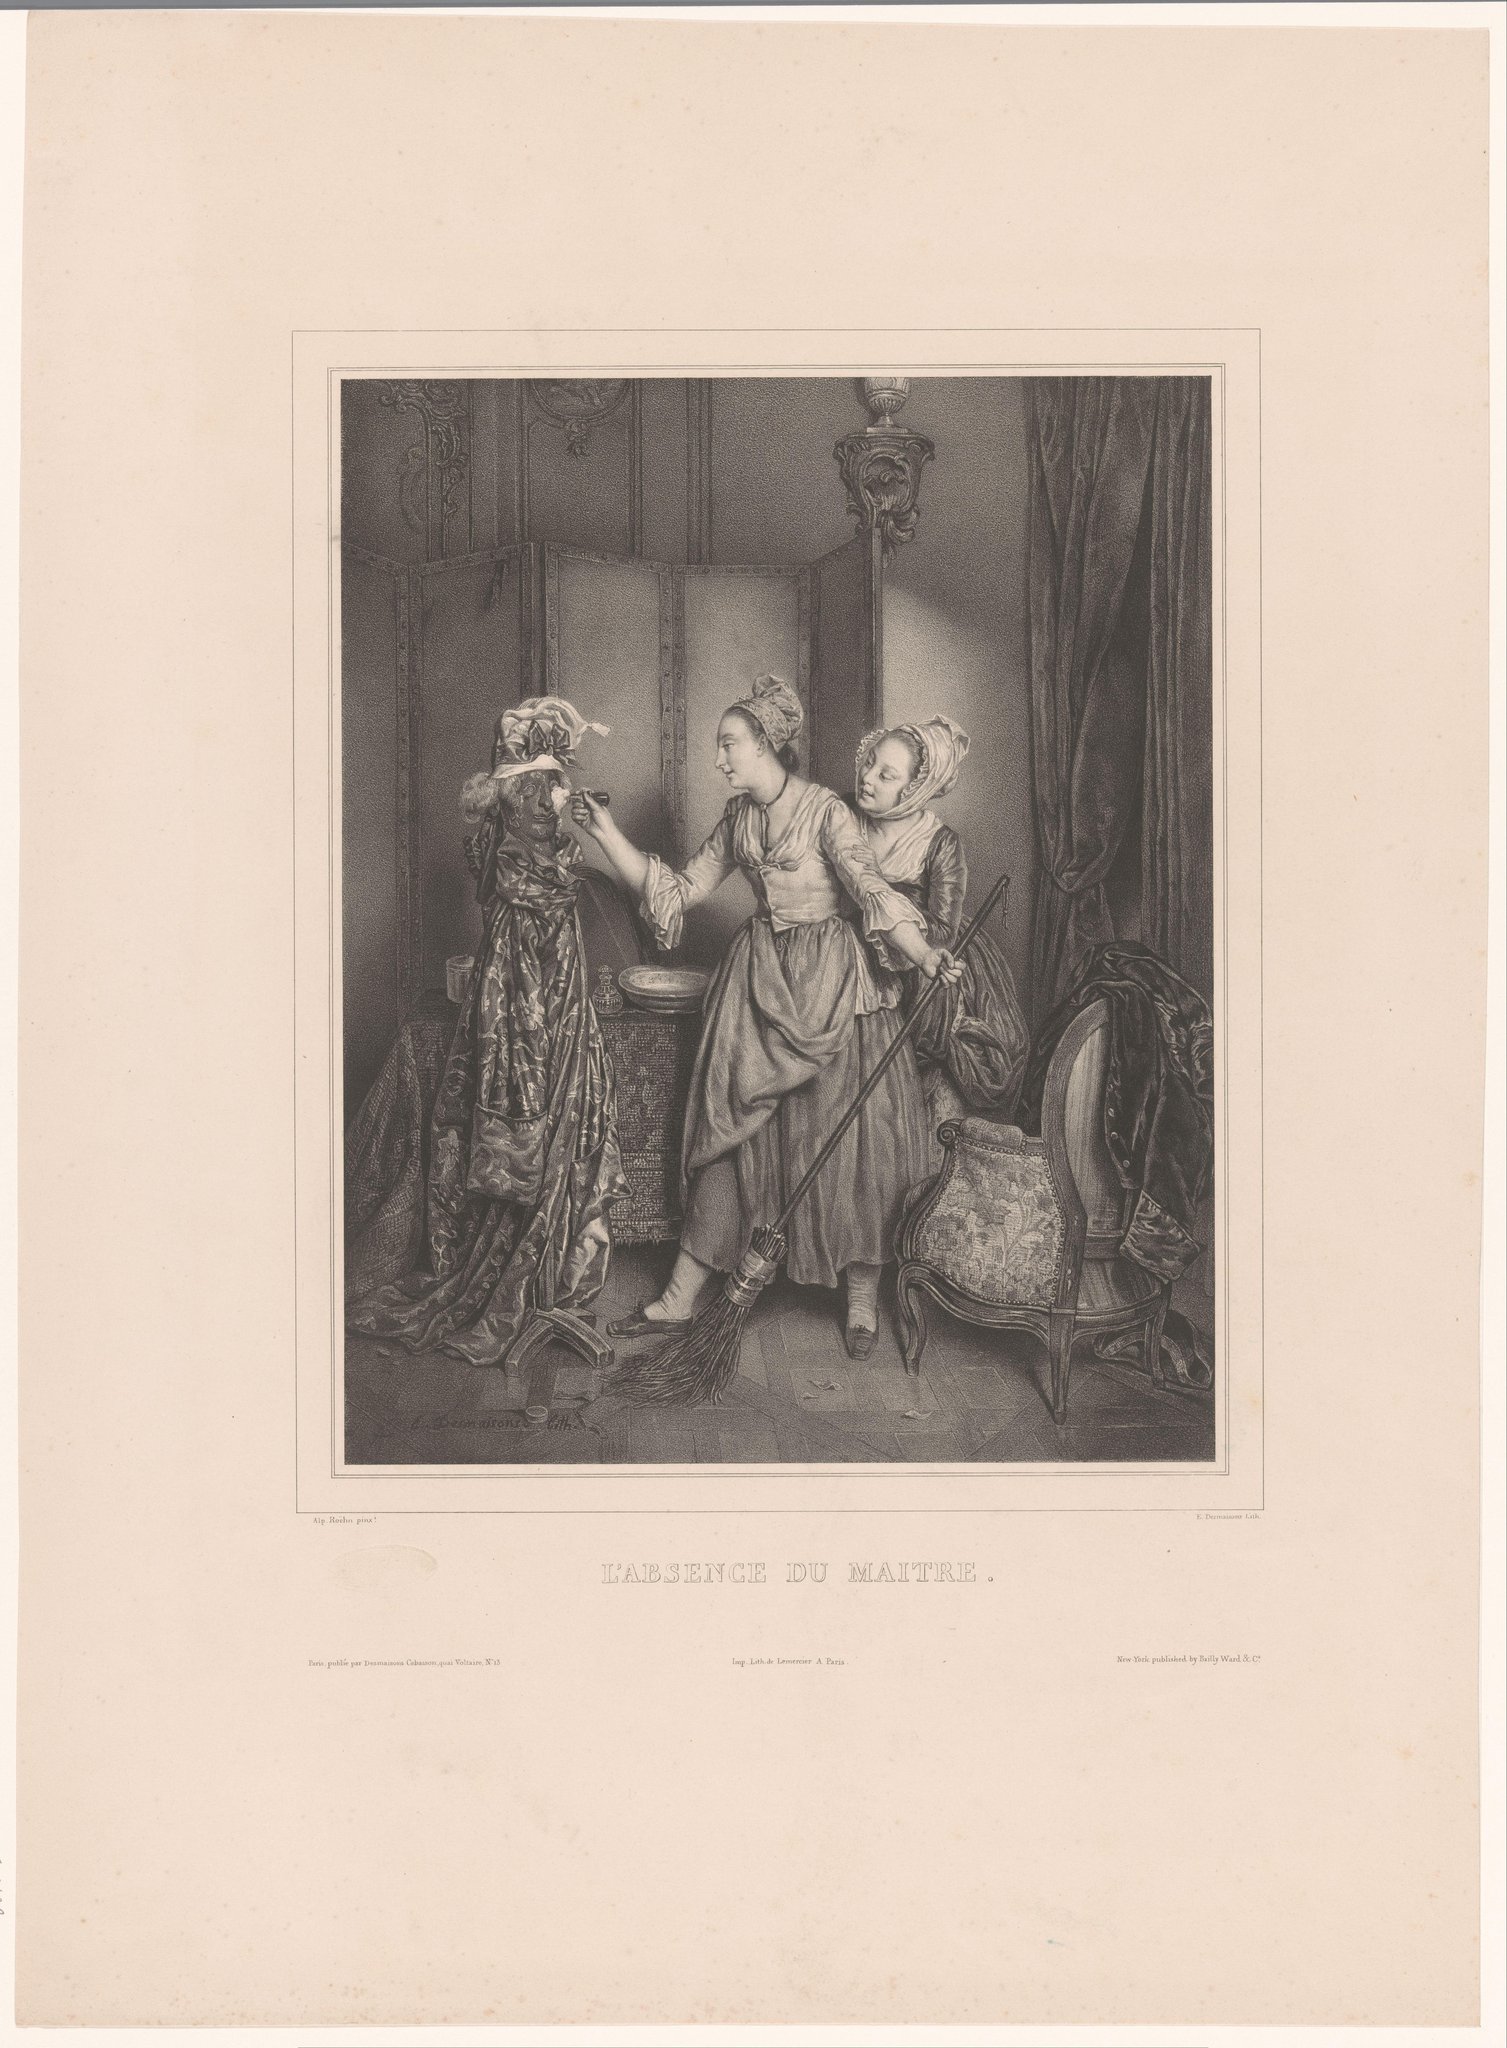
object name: print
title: L'absence du maitre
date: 1837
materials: paper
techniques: lithograph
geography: new york city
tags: mischief-making play, housecoat, powder ~ making toilet - aa - (for) women, maid ~ house personnel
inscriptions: collector's mark: Lugt 2228a, check stamp: Lugt 5001